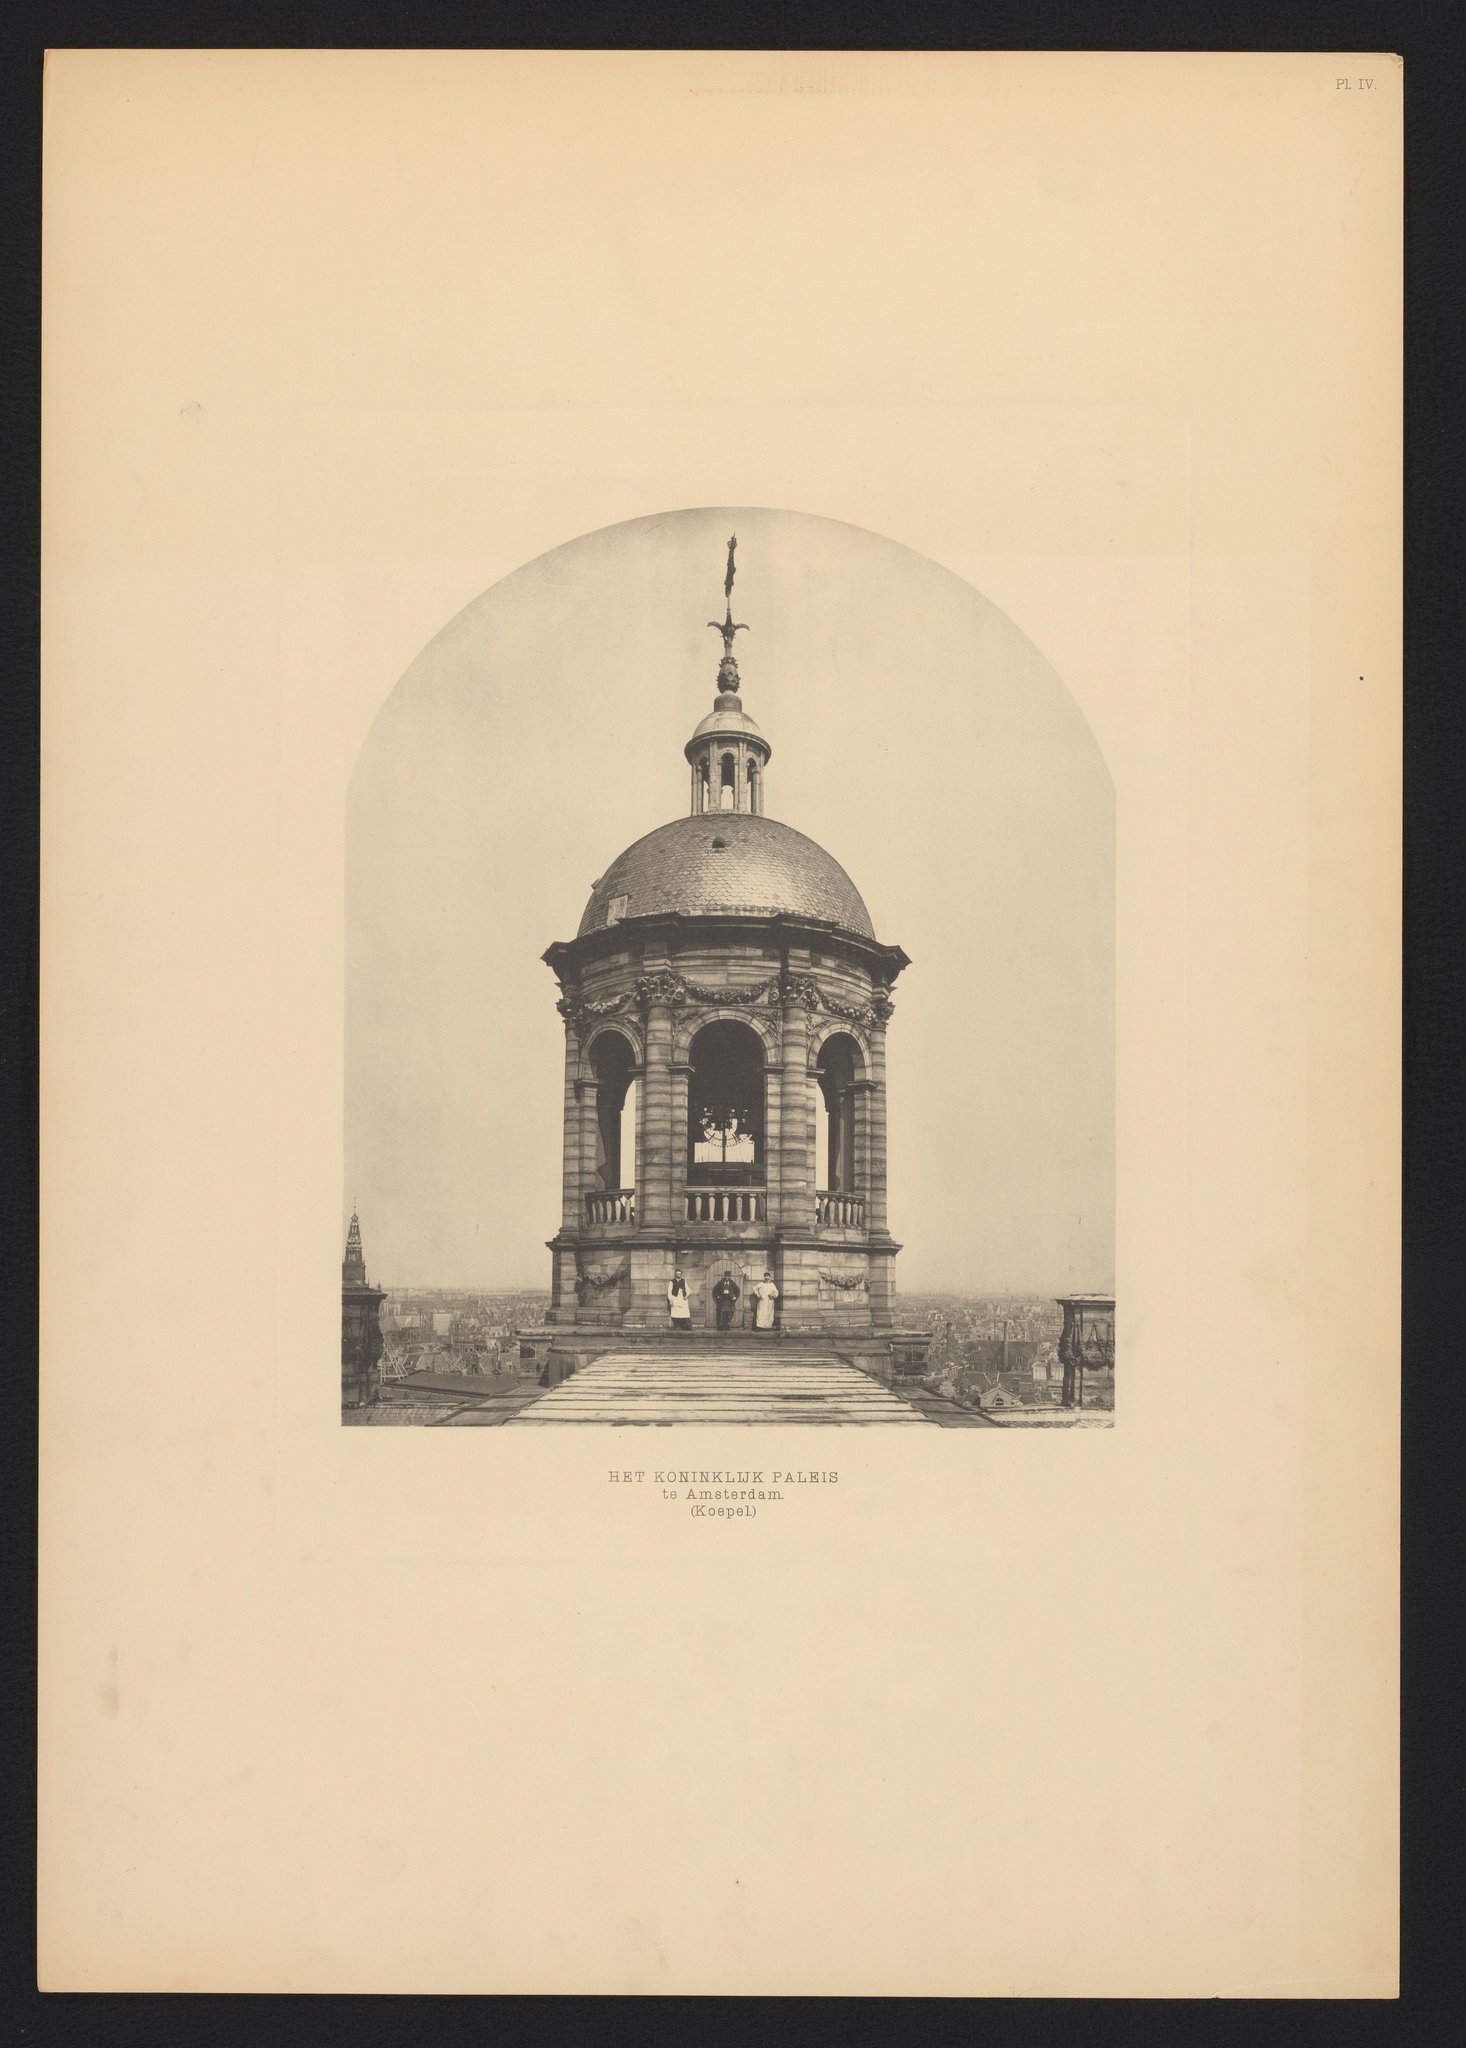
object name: fotomechanisch procedé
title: Het Koninklijk Paleis te Amsterdam, Leiden/Haarlem [1899]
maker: Anonymous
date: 1898-1899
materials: cardboard, paper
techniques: photograph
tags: palace, royal palace of amsterdam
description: Het Koninklijk Paleis te Amsterdam. (Koepel.)